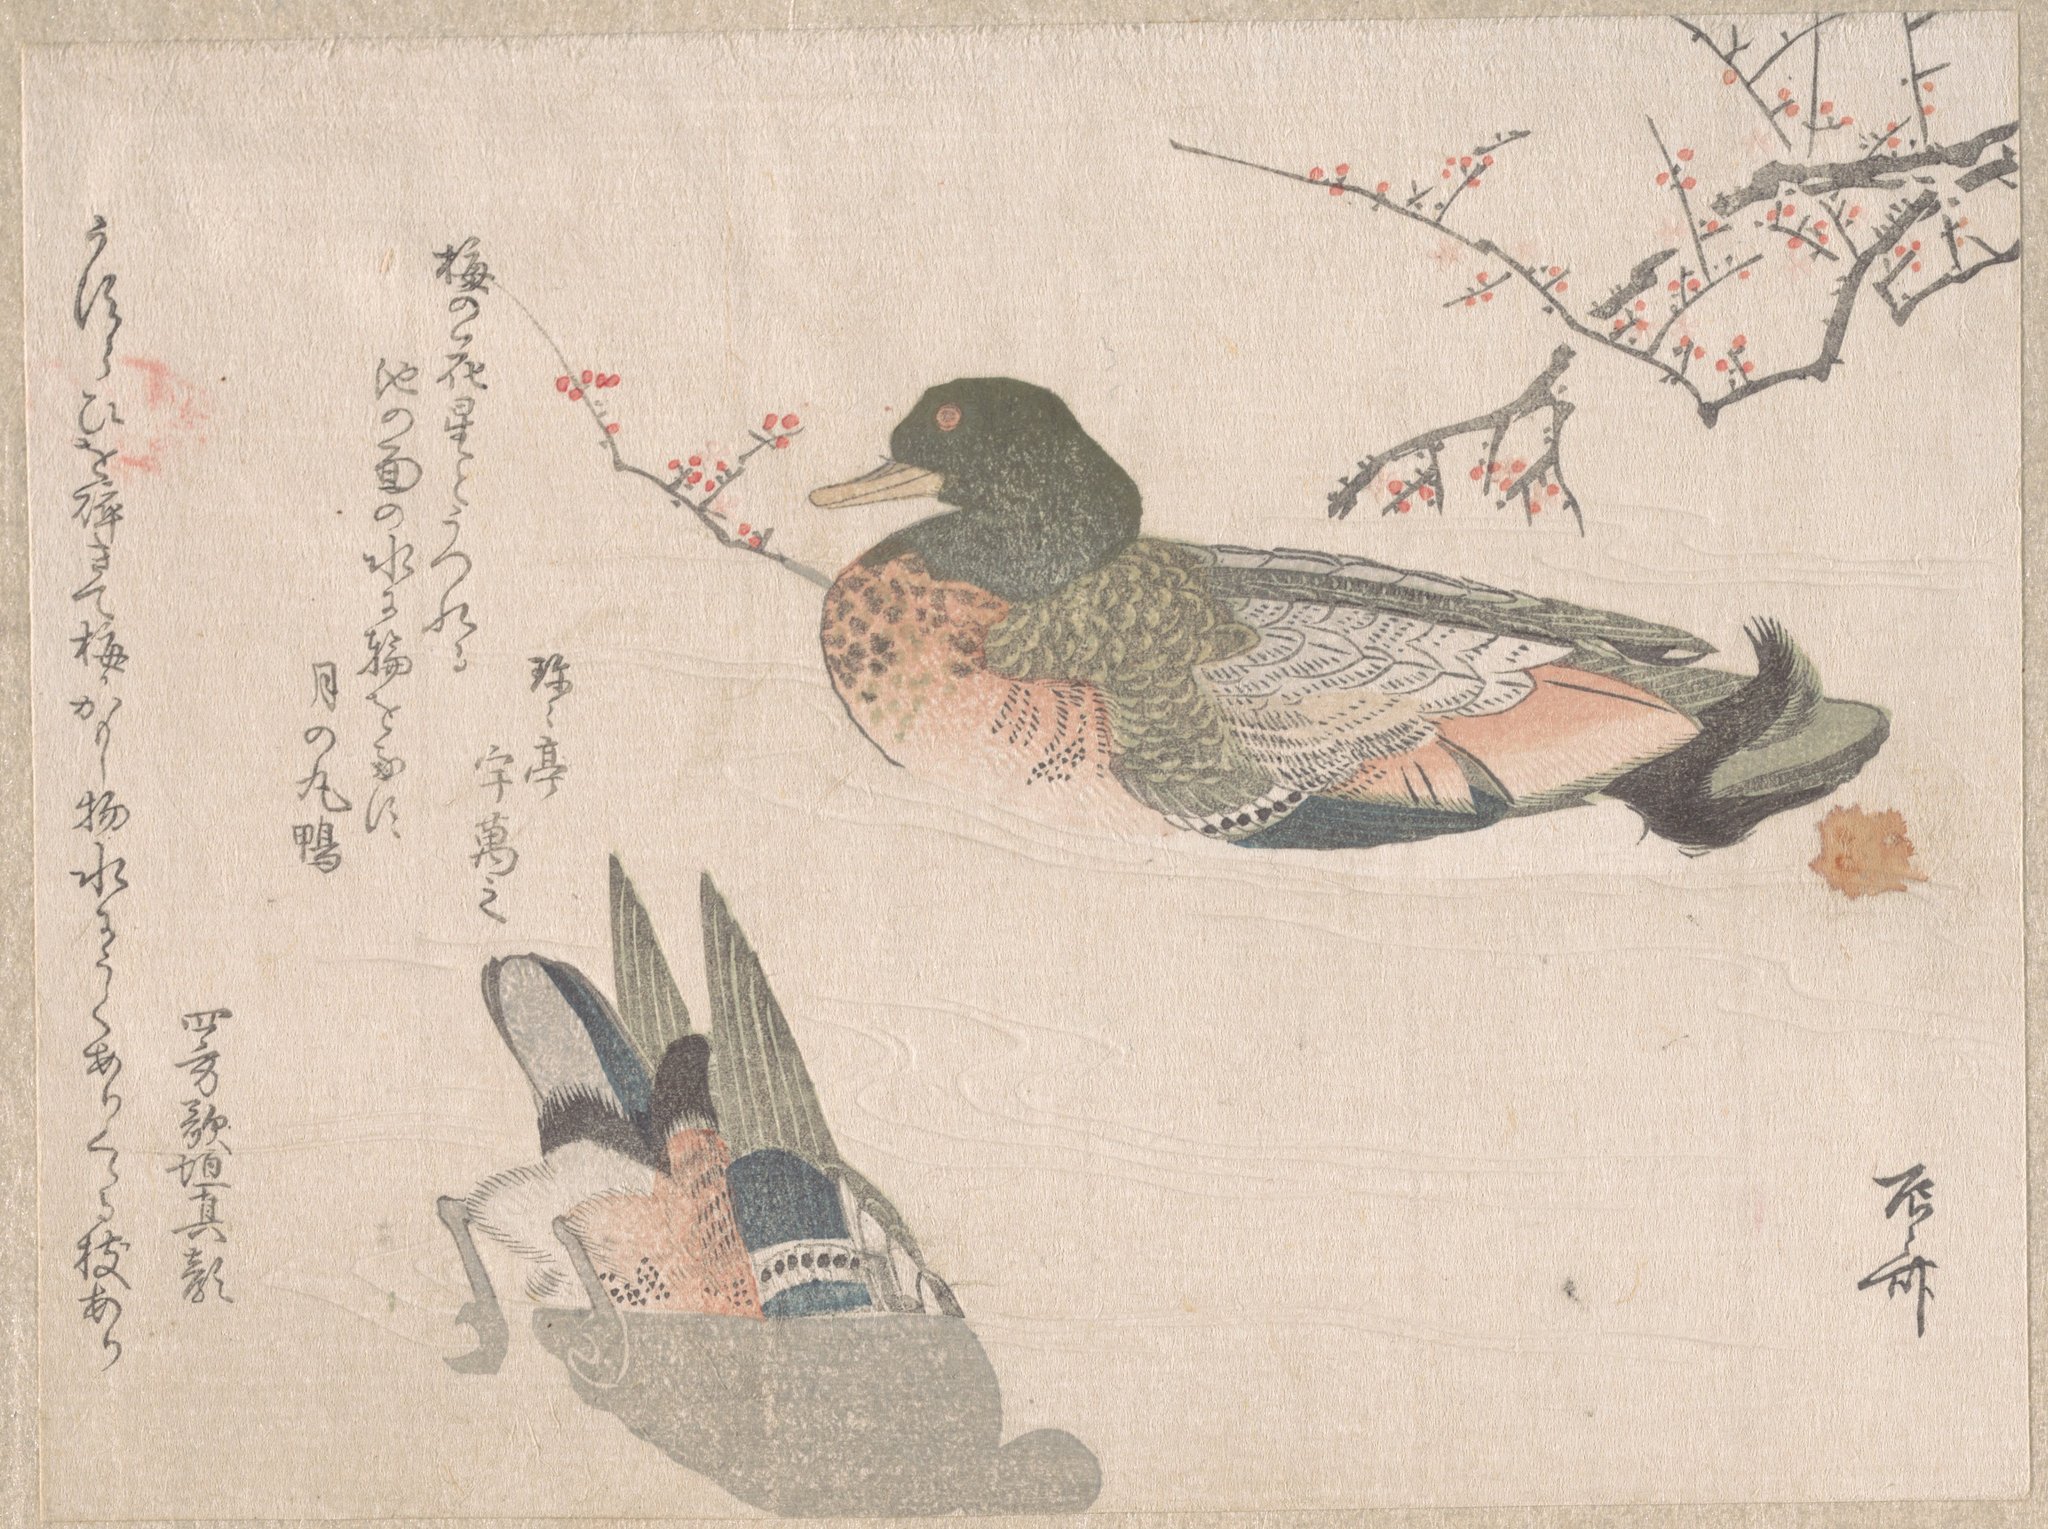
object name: woodblock print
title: Pair of Ducks Swimming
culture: japanese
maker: ryūryūkyo shinsai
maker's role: artist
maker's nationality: japanese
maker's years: 1799-1823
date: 1801-1900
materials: ink, paper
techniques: surimono, woodblock print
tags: ducks